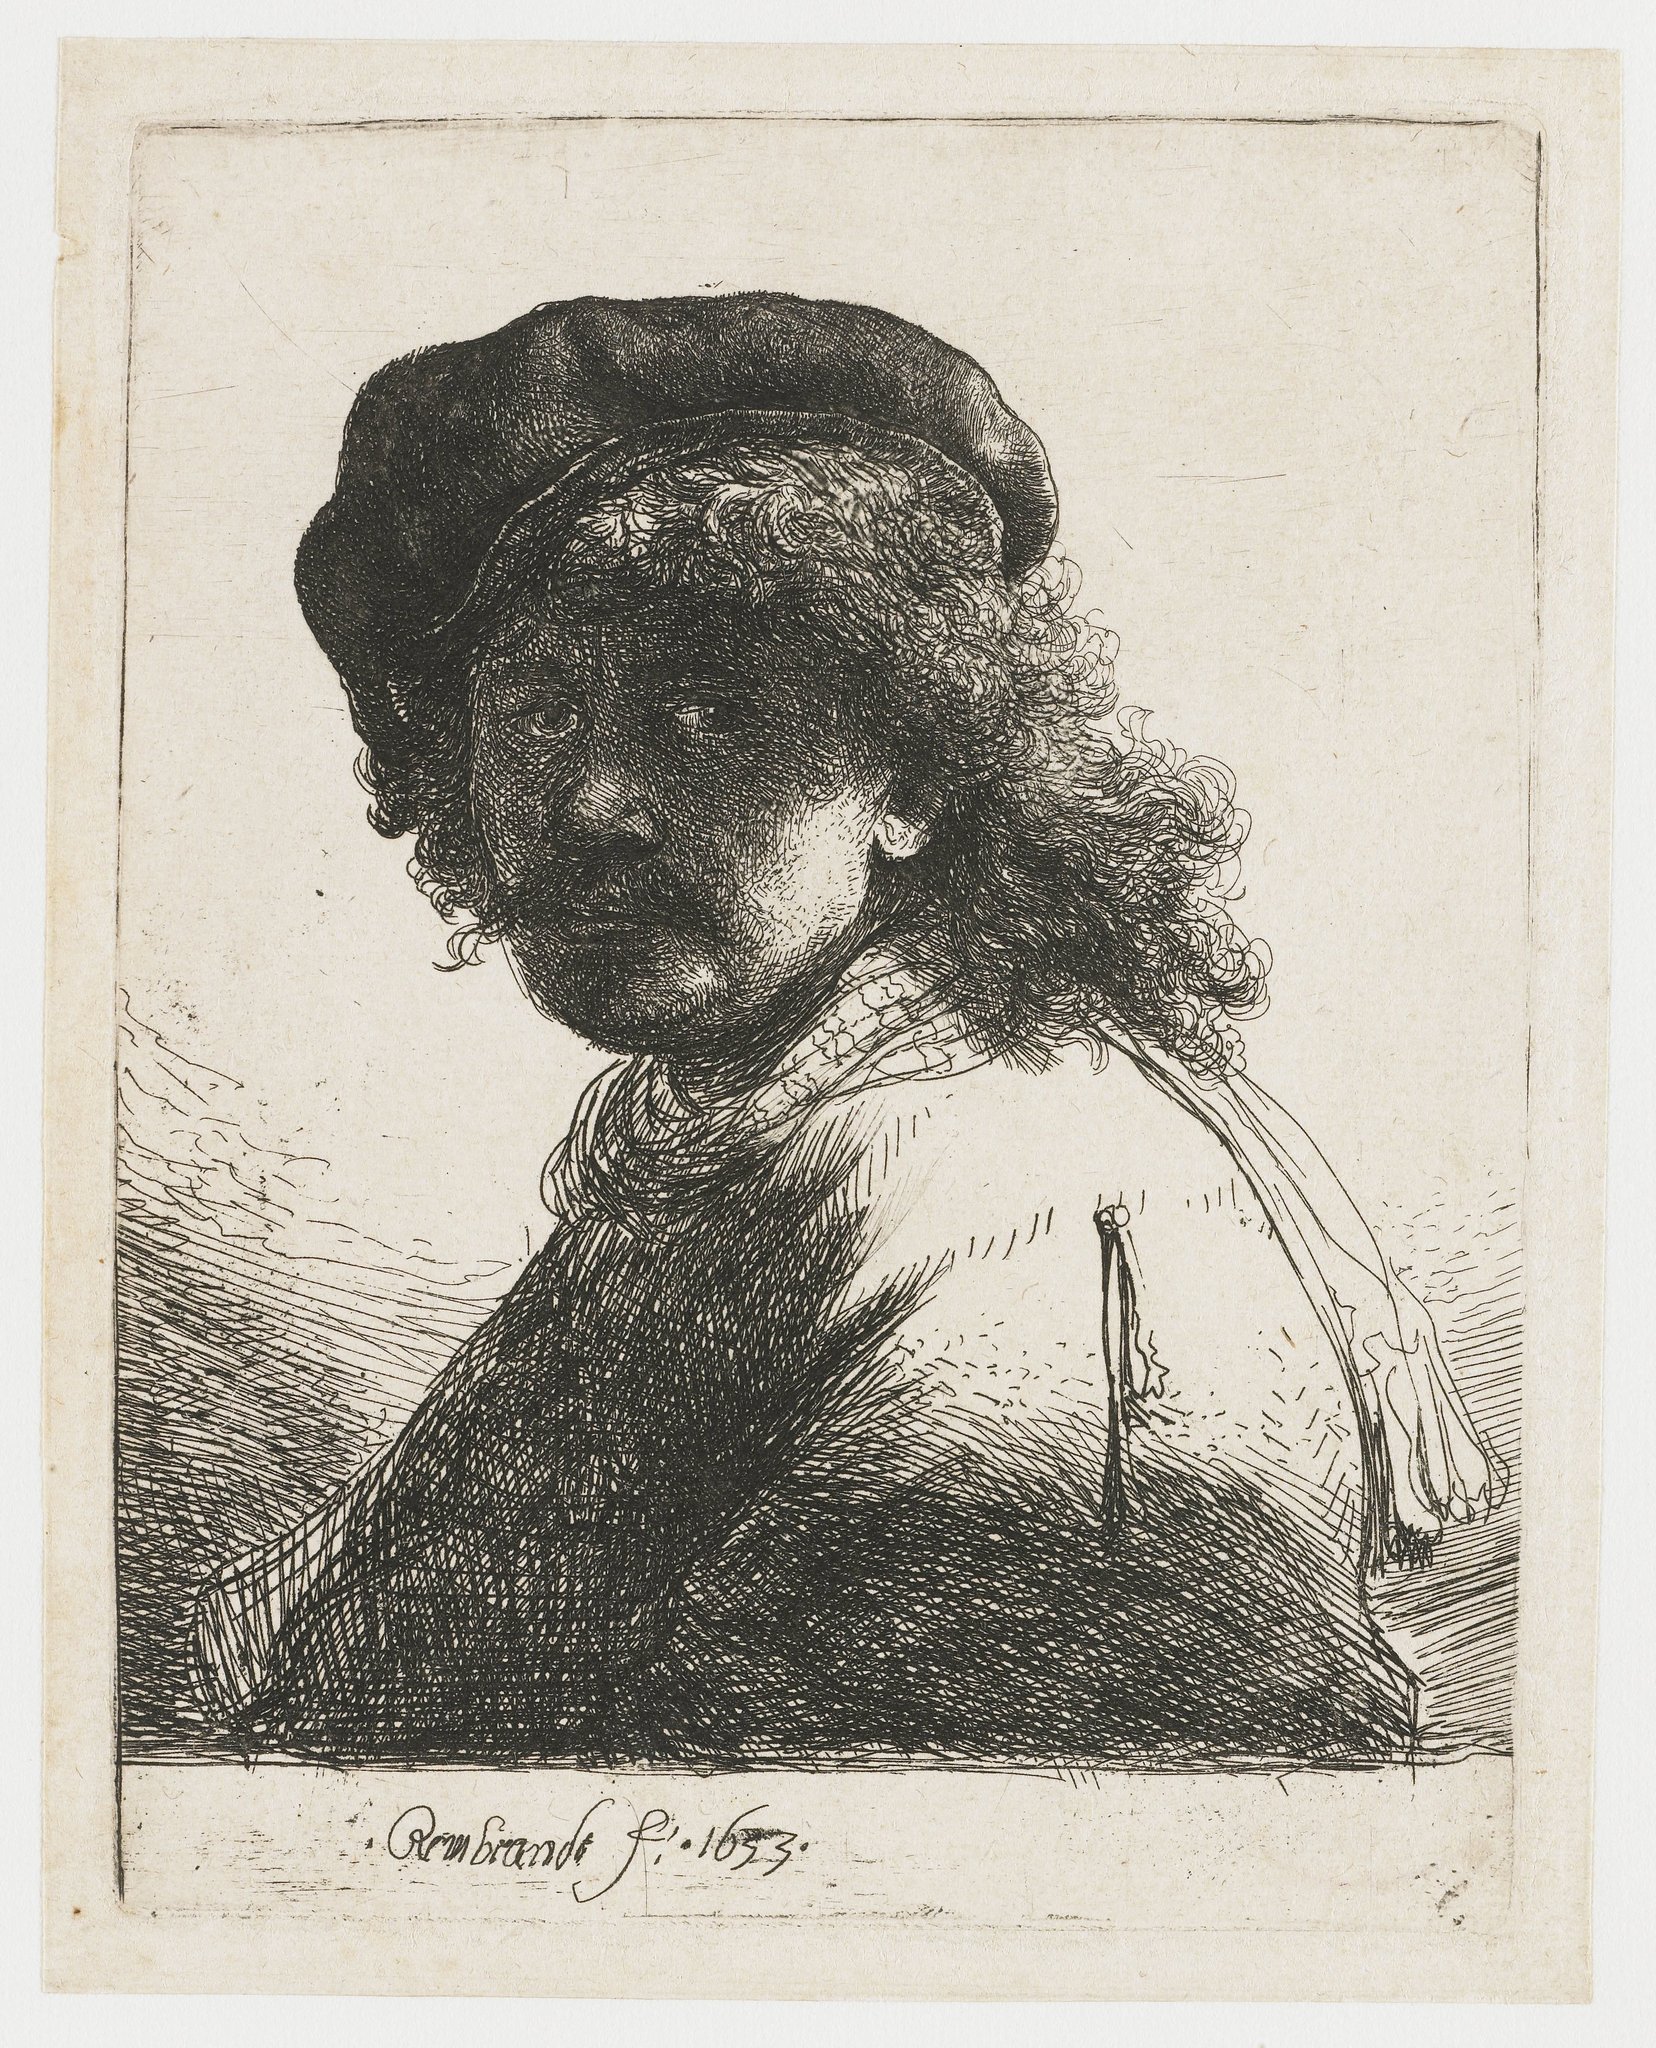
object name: print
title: Self-portrait in a Cap and Scarf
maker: rembrandt van rijn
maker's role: draughtsman, painter, print maker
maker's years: 1606-1669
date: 1633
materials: paper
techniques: etching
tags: leiden, amsterdam, painter, print maker, rembrandt van rijn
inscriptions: collector's mark: Lugt 240, signature and date: ‘Rembrandt f. 1633’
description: After Rembrandt painted a highly unusual self-portrait with his face in shadow around 1628 (elsewhere in this gallery), he tried out the same approach in his etchings. This proved to be no easy task. Initially the details in shadow could hardly be recognized. He succeeded only with a renewed attempt in 1633 (middle).